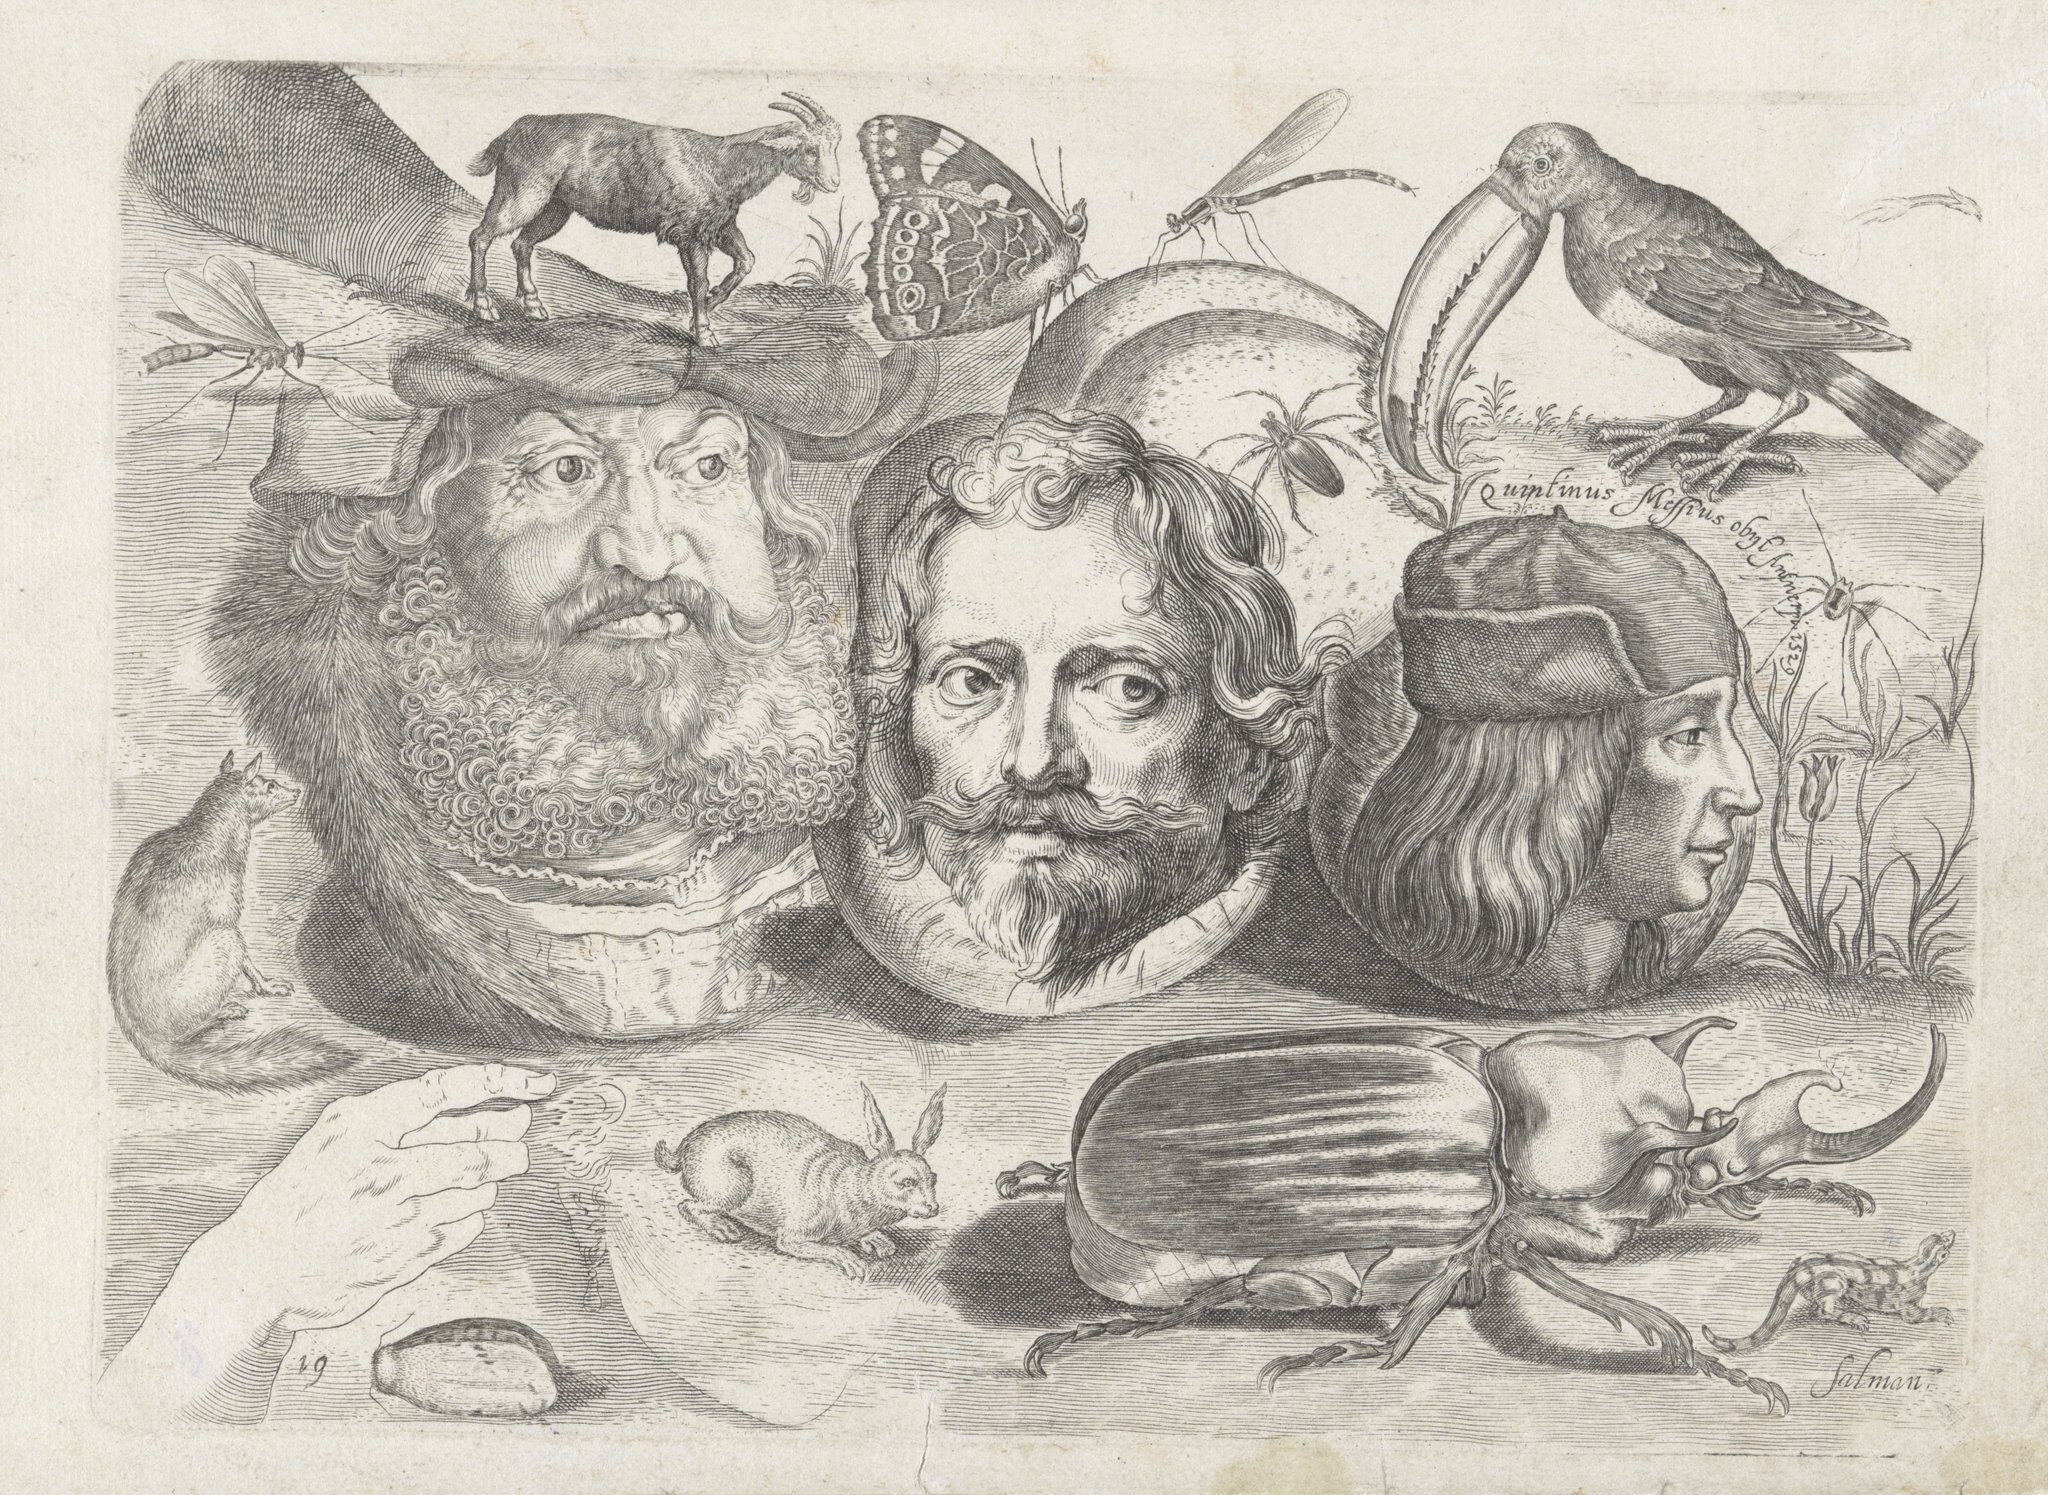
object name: print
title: Studieblad met tekenvoorbeelden: portretten, dieren, insecten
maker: michael snijders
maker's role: print maker, publisher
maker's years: 1586-1672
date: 1610-1672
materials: paper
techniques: engraving, etching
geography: antwerp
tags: louvain, quinten massijs (i), antwerp, london, painter, print maker, draughtsman, anthony van dyck, head (human), model-books ~ implements of painter, hand, beasts of prey, predatory animals, fruits: peach, flowers: tulip, goat, insects, other birds: toucan, insects: beetle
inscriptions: collector's mark: Lugt 2228, collector's mark: Lugt 3751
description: Negentiende prent uit een serie met tekenvoorbeelden. Studieblad met koppen, dieren en insecten. In het midden drie portretten, van links naar rechts: Frederik III de Wijze (keurvorst van Saksen), Anthony van Dyck en Quinten Massijs (de laatste met zijn naam, sterfplaats en -jaar). Daaromheen diverse dieren en insecten waaronder een toekan (naar illustratie in Gessner), vos, haas (naar Aegidius Sadeler) en olifantskever en vlinder (naar Hoefnagel) .